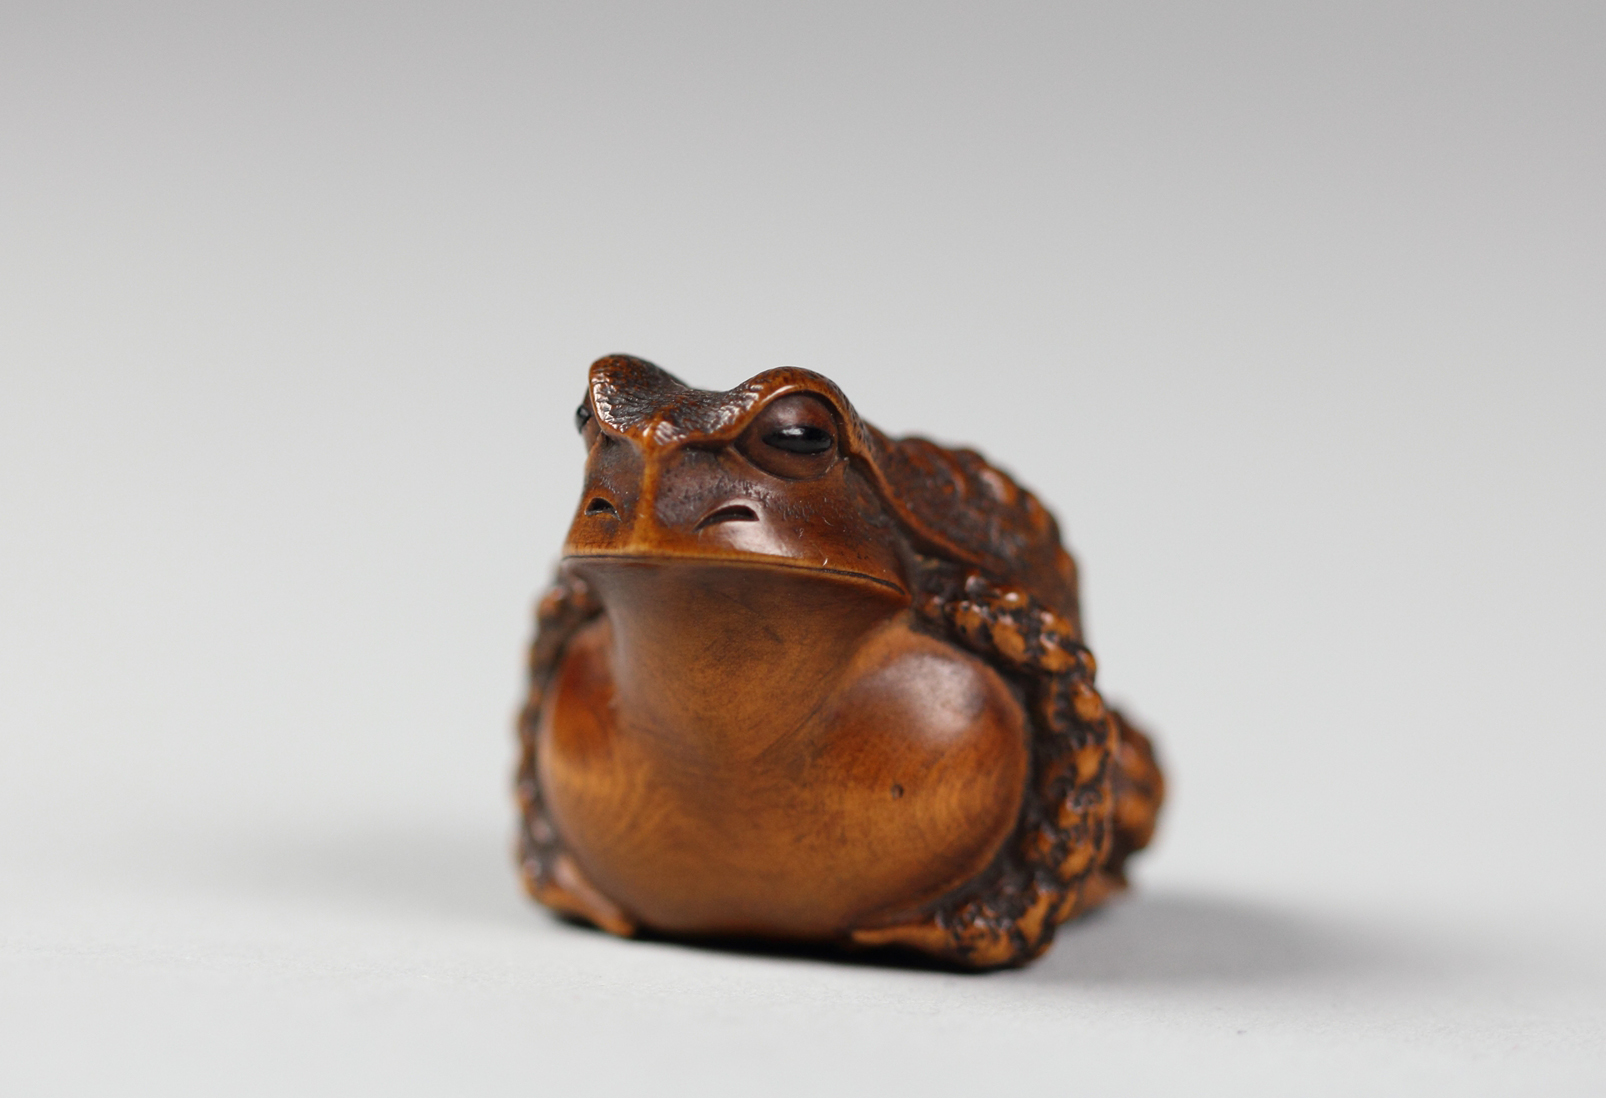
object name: netsuke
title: Netsuke of Frog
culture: japanese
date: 1701-1800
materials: wood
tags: frogs